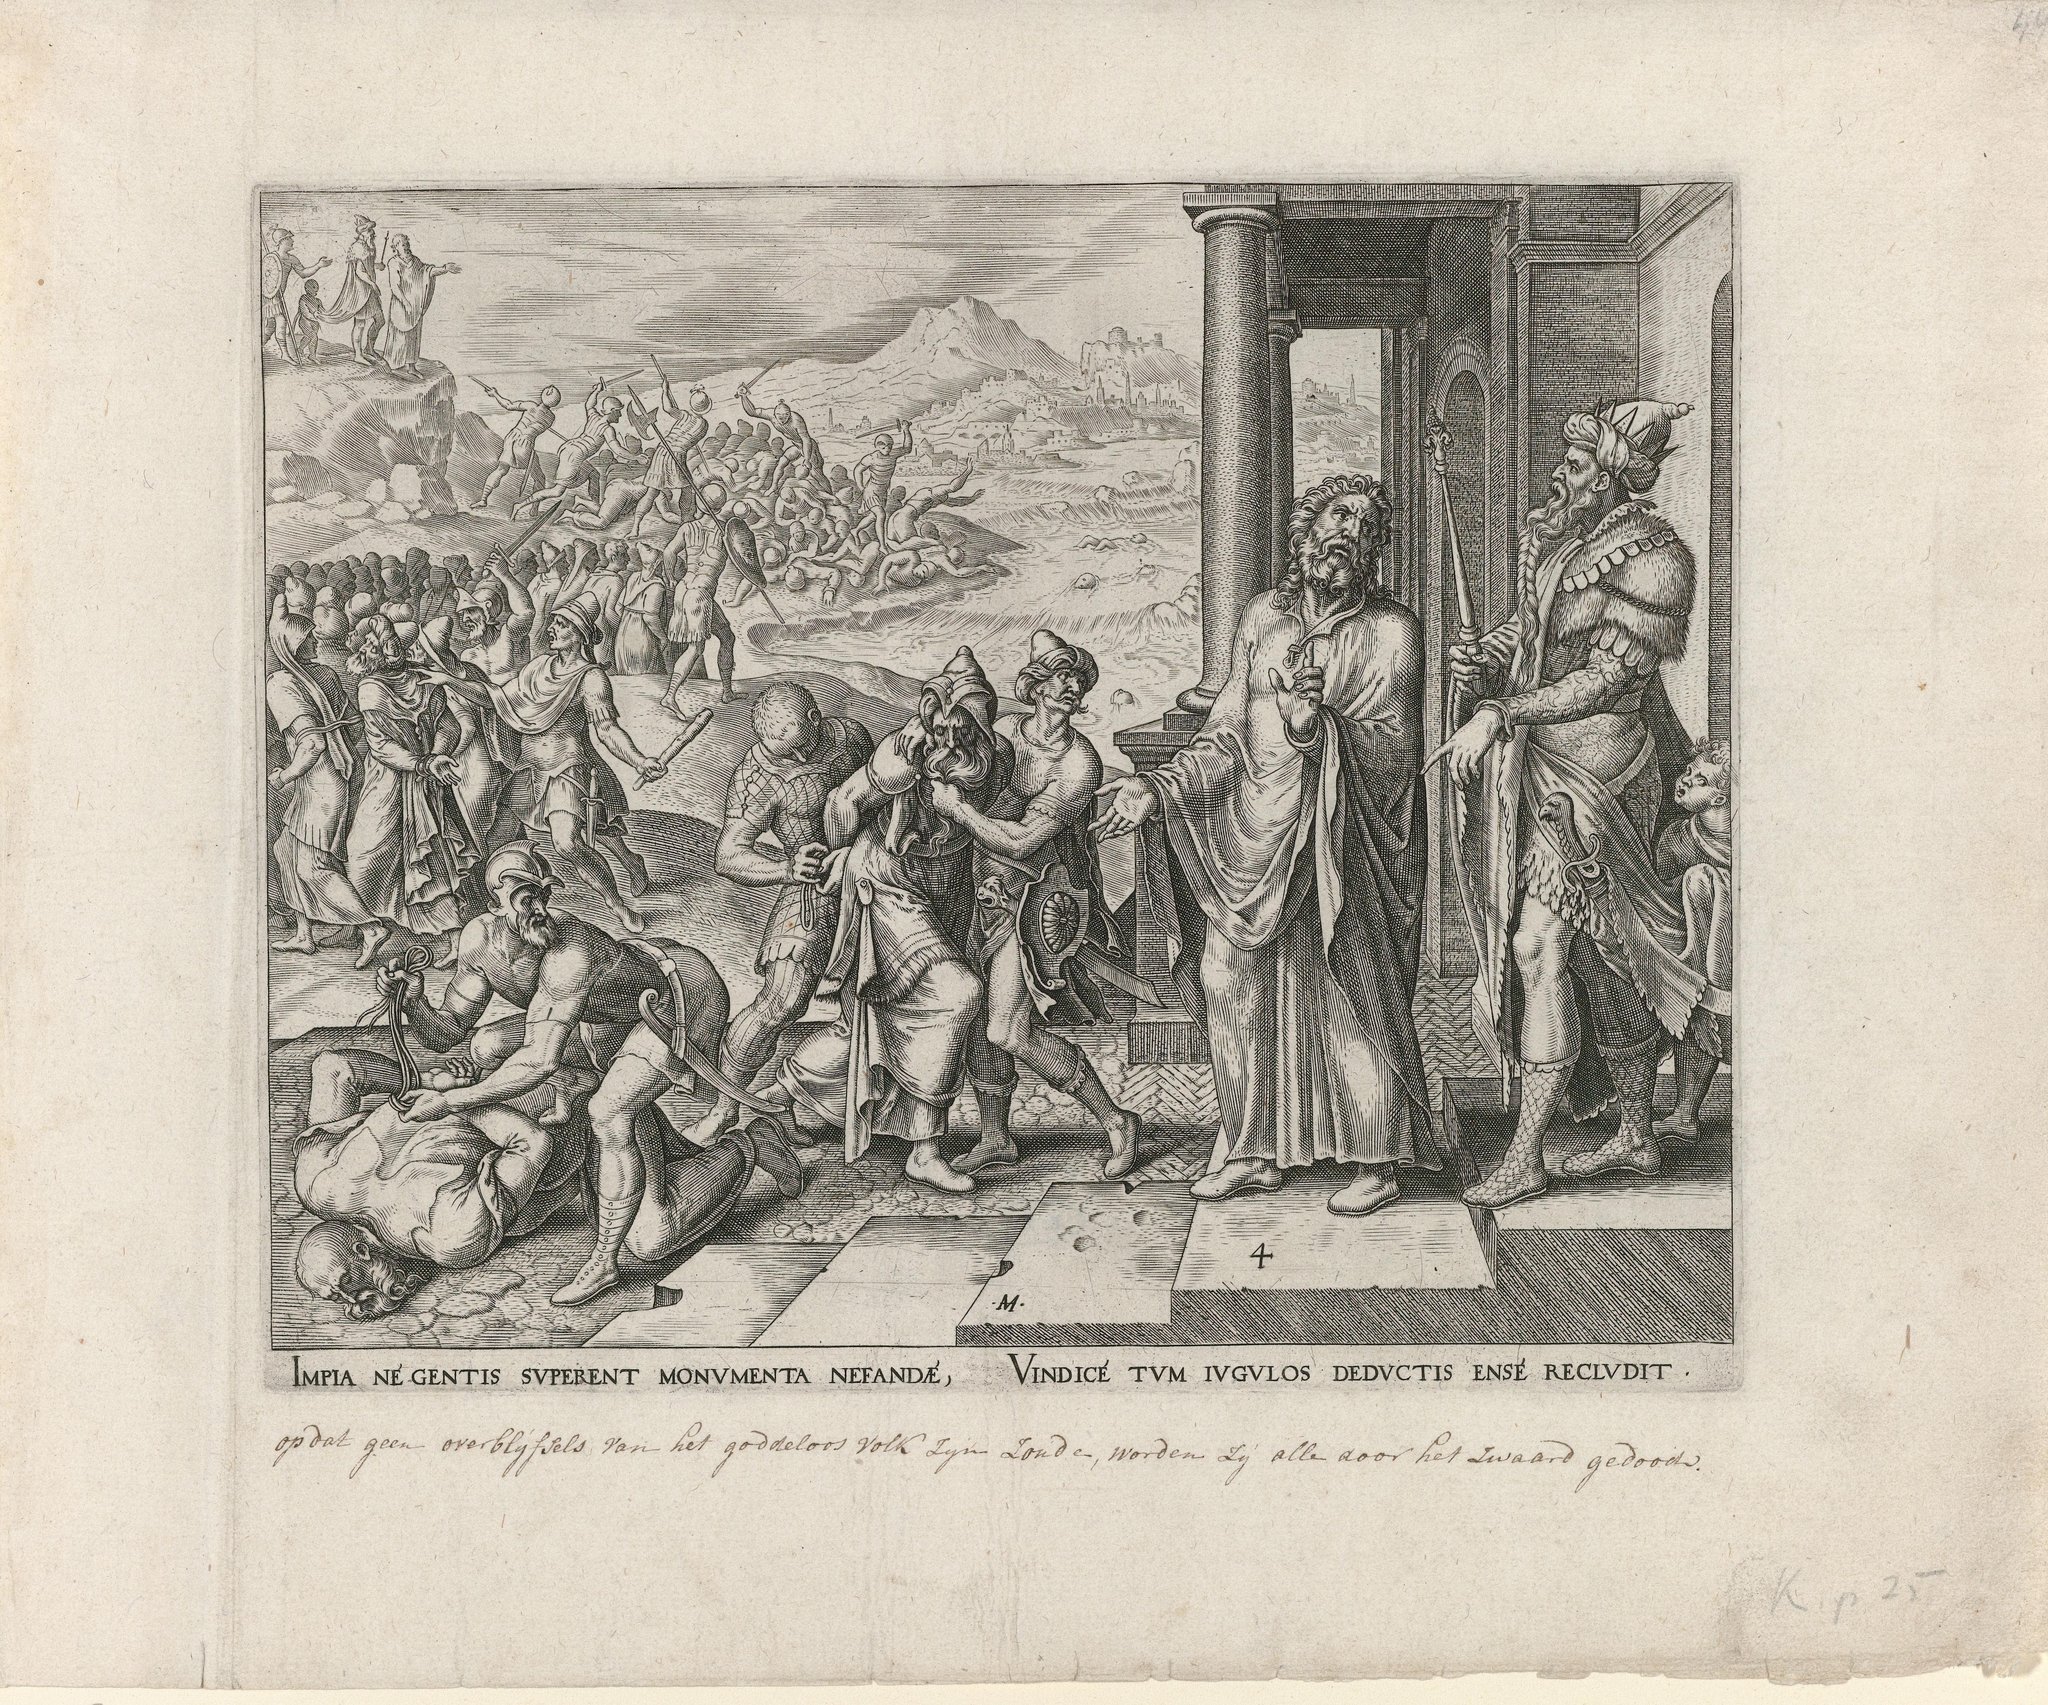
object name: print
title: Afslachting van de priesters van Baäl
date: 1567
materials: paper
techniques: engraving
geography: haarlem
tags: at elijah's order, the priests of baal are taken to the brook of kishon and slain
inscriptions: inscription: ‘Opdat geen overblijfsels van het goddeloos volk zijn zouden worden zij alle door het zwaad gedood’, collector's mark: Lugt 2228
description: Elia beveelt alle priesters van Baäl gevangen te nemen en naar de rivier Kison brengen. Daar worden ze geëxecuteerd. Naast hem koning Achab. De prent heeft een Latijns onderschrift en is deel van een serie over Elia en de priesters van Baäl.